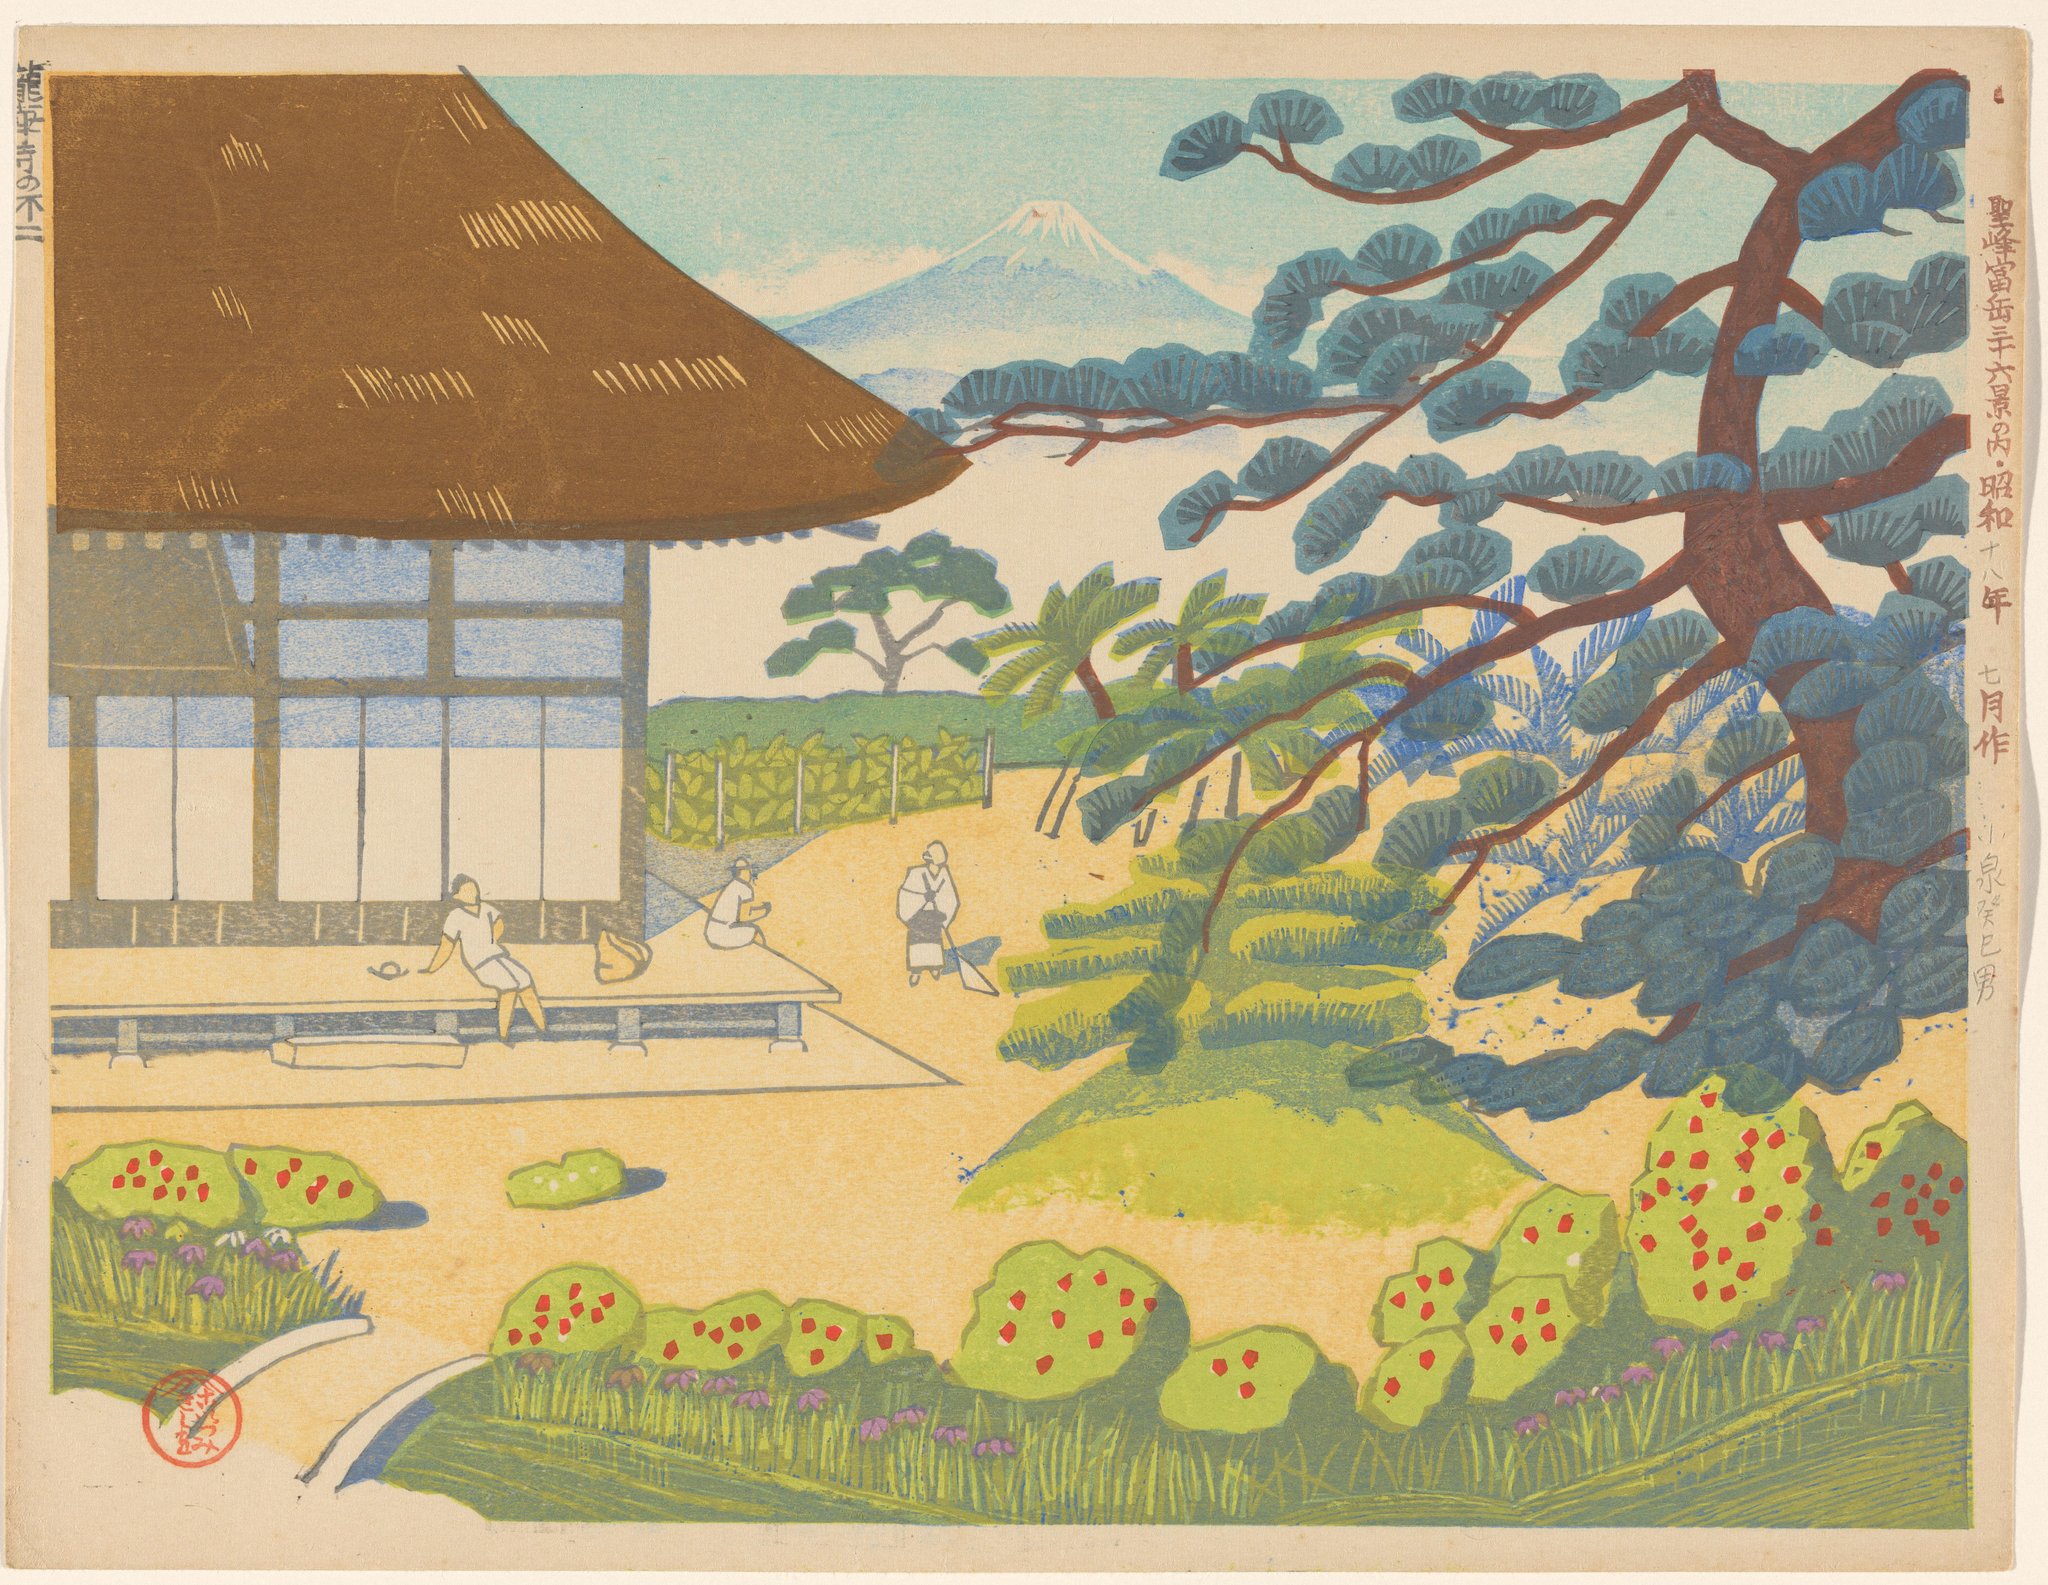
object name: print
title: Ryūgeji no Fuji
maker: koizumi kishio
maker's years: 1893-1945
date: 1907-1943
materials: paper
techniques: woodcut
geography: japan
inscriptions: signature: ‘小泉癸巳男’, seal: ‘こいづみきしを’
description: Twee bezoekers aan de Ryūge-tempel nabij Shizuoka zitten in het zonlicht op de veranda van de hoofdhal. Een tempelbediende harkt de kiezels van de tuin. De Fuji-berg is zichtbaar in de verte. Koizumi Kishio begon in 1940 aan zijn project 'Zesendertig gezichten op de heilige berg Fuji', een knipoog naar de welbekende prenten uit de jaren 1830 van Katsushika Hokusai (1760–1849). Vanwege de geallieerde bombardementen vluchtte hij naar zijn schoonouders in Saitama, ten noorden van Tokyo. Hij voltooide 23 ontwerpen voor hij bezweek aan ziekte in 1945.